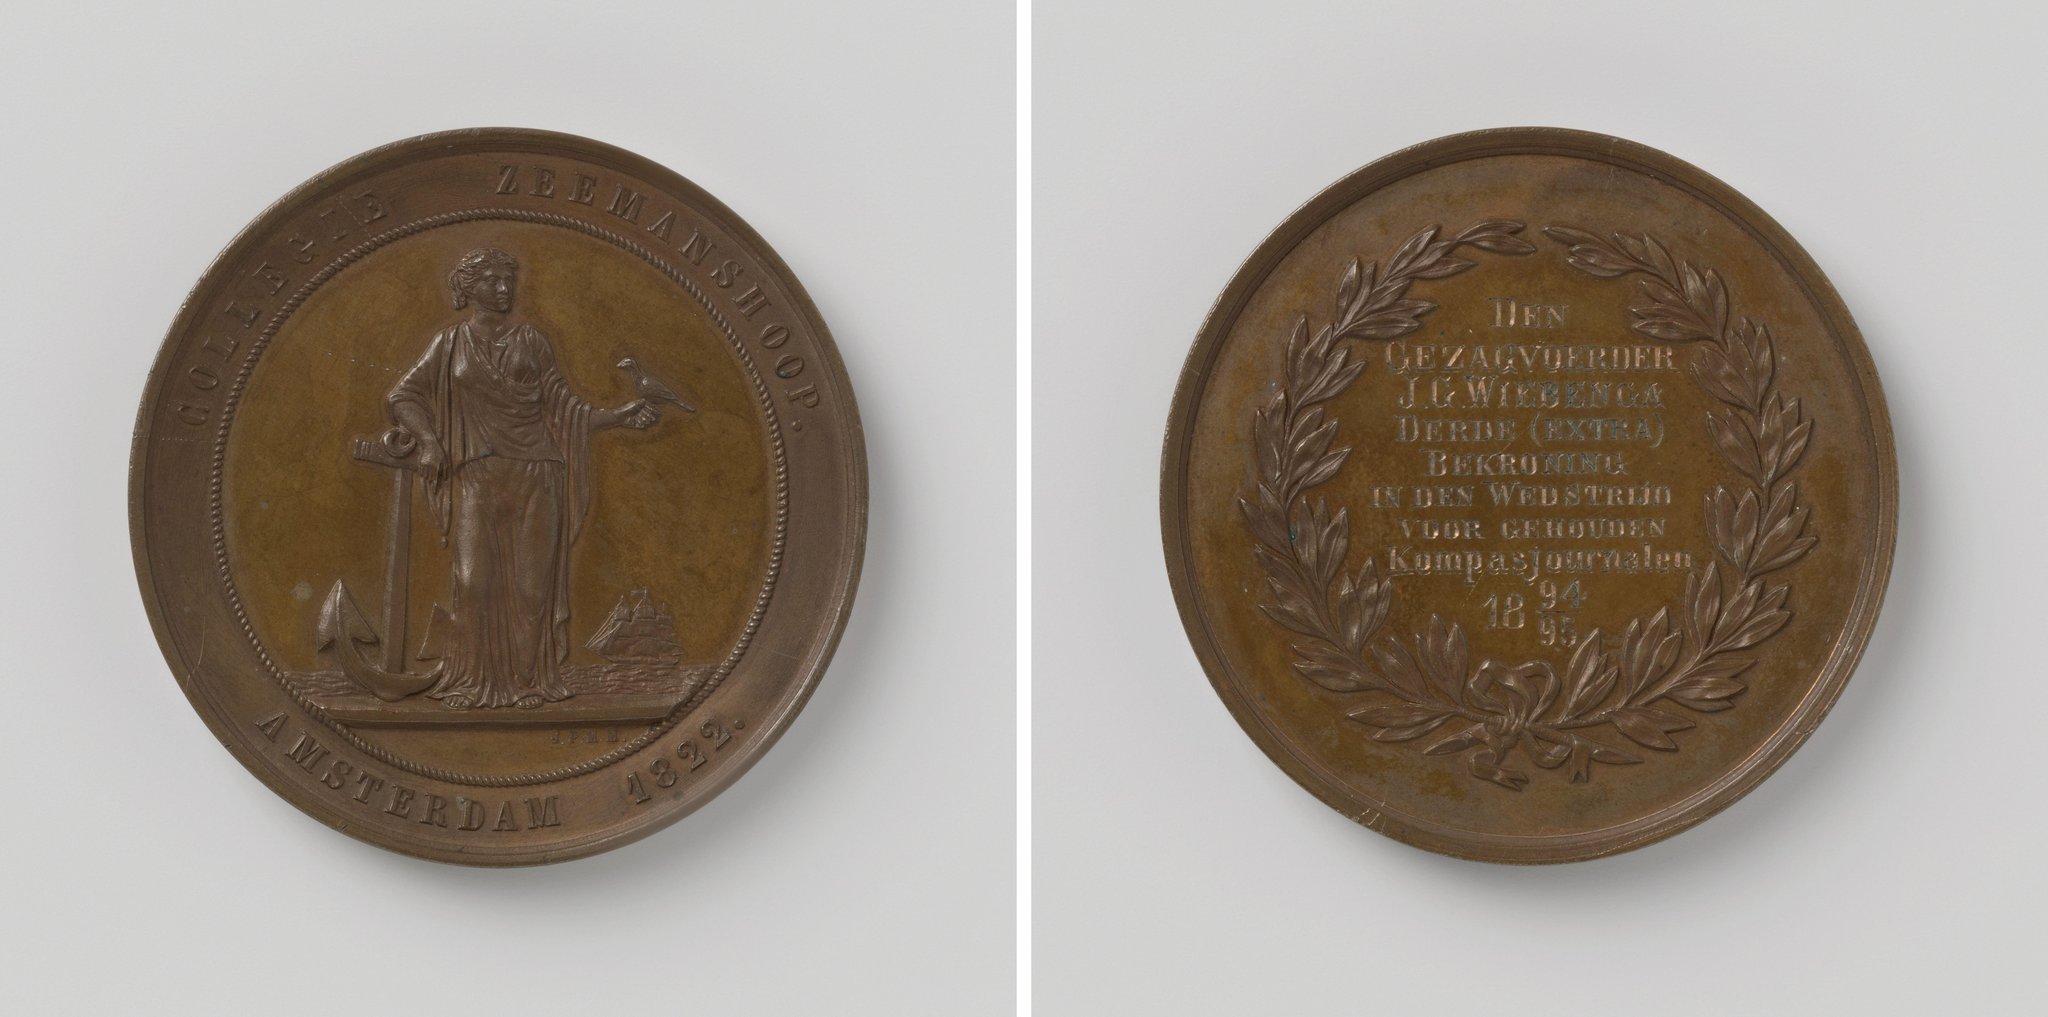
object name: medal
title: Collegie Zeemanshoop te Amsterdam, penning uitgereikt aan gezagvoerder J.G. Wiebenga als derde (extra) bekroning in de wedstrijd voor kompasjournalen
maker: johan philip mathias menger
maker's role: medailleur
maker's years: 1845-1905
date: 1877-1895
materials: bronze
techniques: engraving, striking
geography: utrecht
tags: amsterdam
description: Bronzen penning. Voorzijde: Hoop, afgebeeld als vrouw met vogeltje in uitgestrekte linkerhand, leunt op anker; op achtergrond schip op zee binnen omschrift. Keerzijde: opschrift binnen lauwerkrans